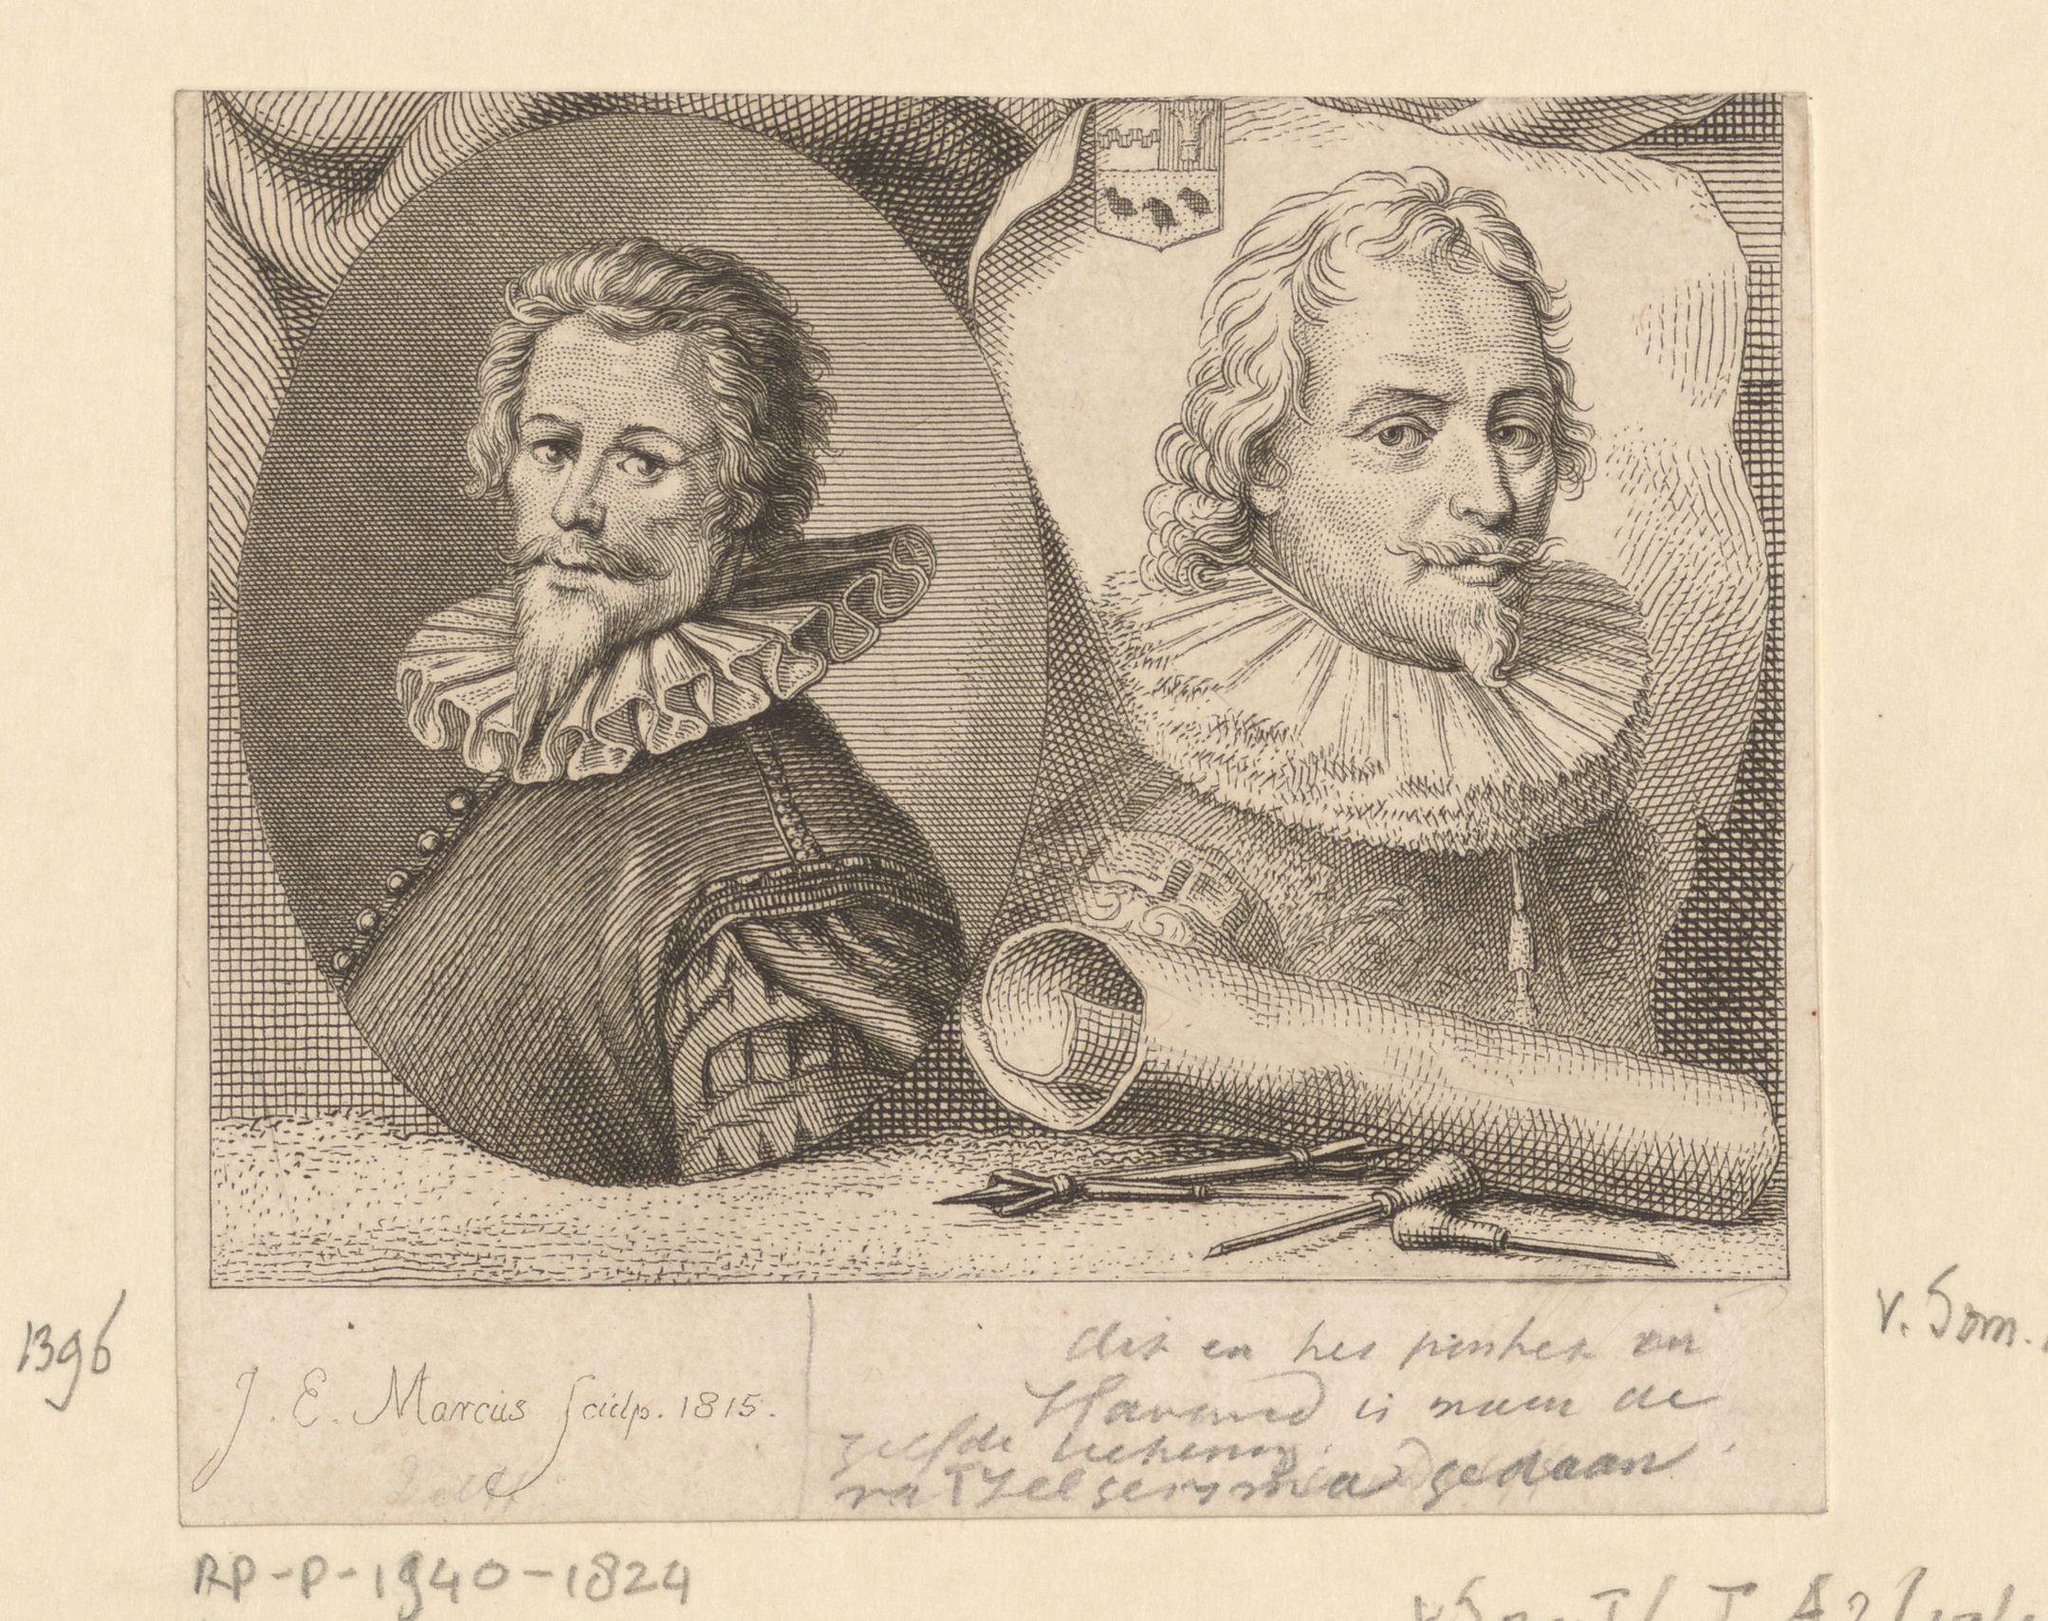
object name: print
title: Portretten van Nicolaas Kornelisz. van Delff en Willem Jacobsz. Delff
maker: jacob ernst marcus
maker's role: draughtsman, print maker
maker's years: 1774-1826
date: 1815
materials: paper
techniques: engraving, etching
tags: delft, print maker, draughtsman, willem jacobsz delff, engraver, etcher, historical persons, portrait, self-portrait of painter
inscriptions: collector's mark: Lugt 2760